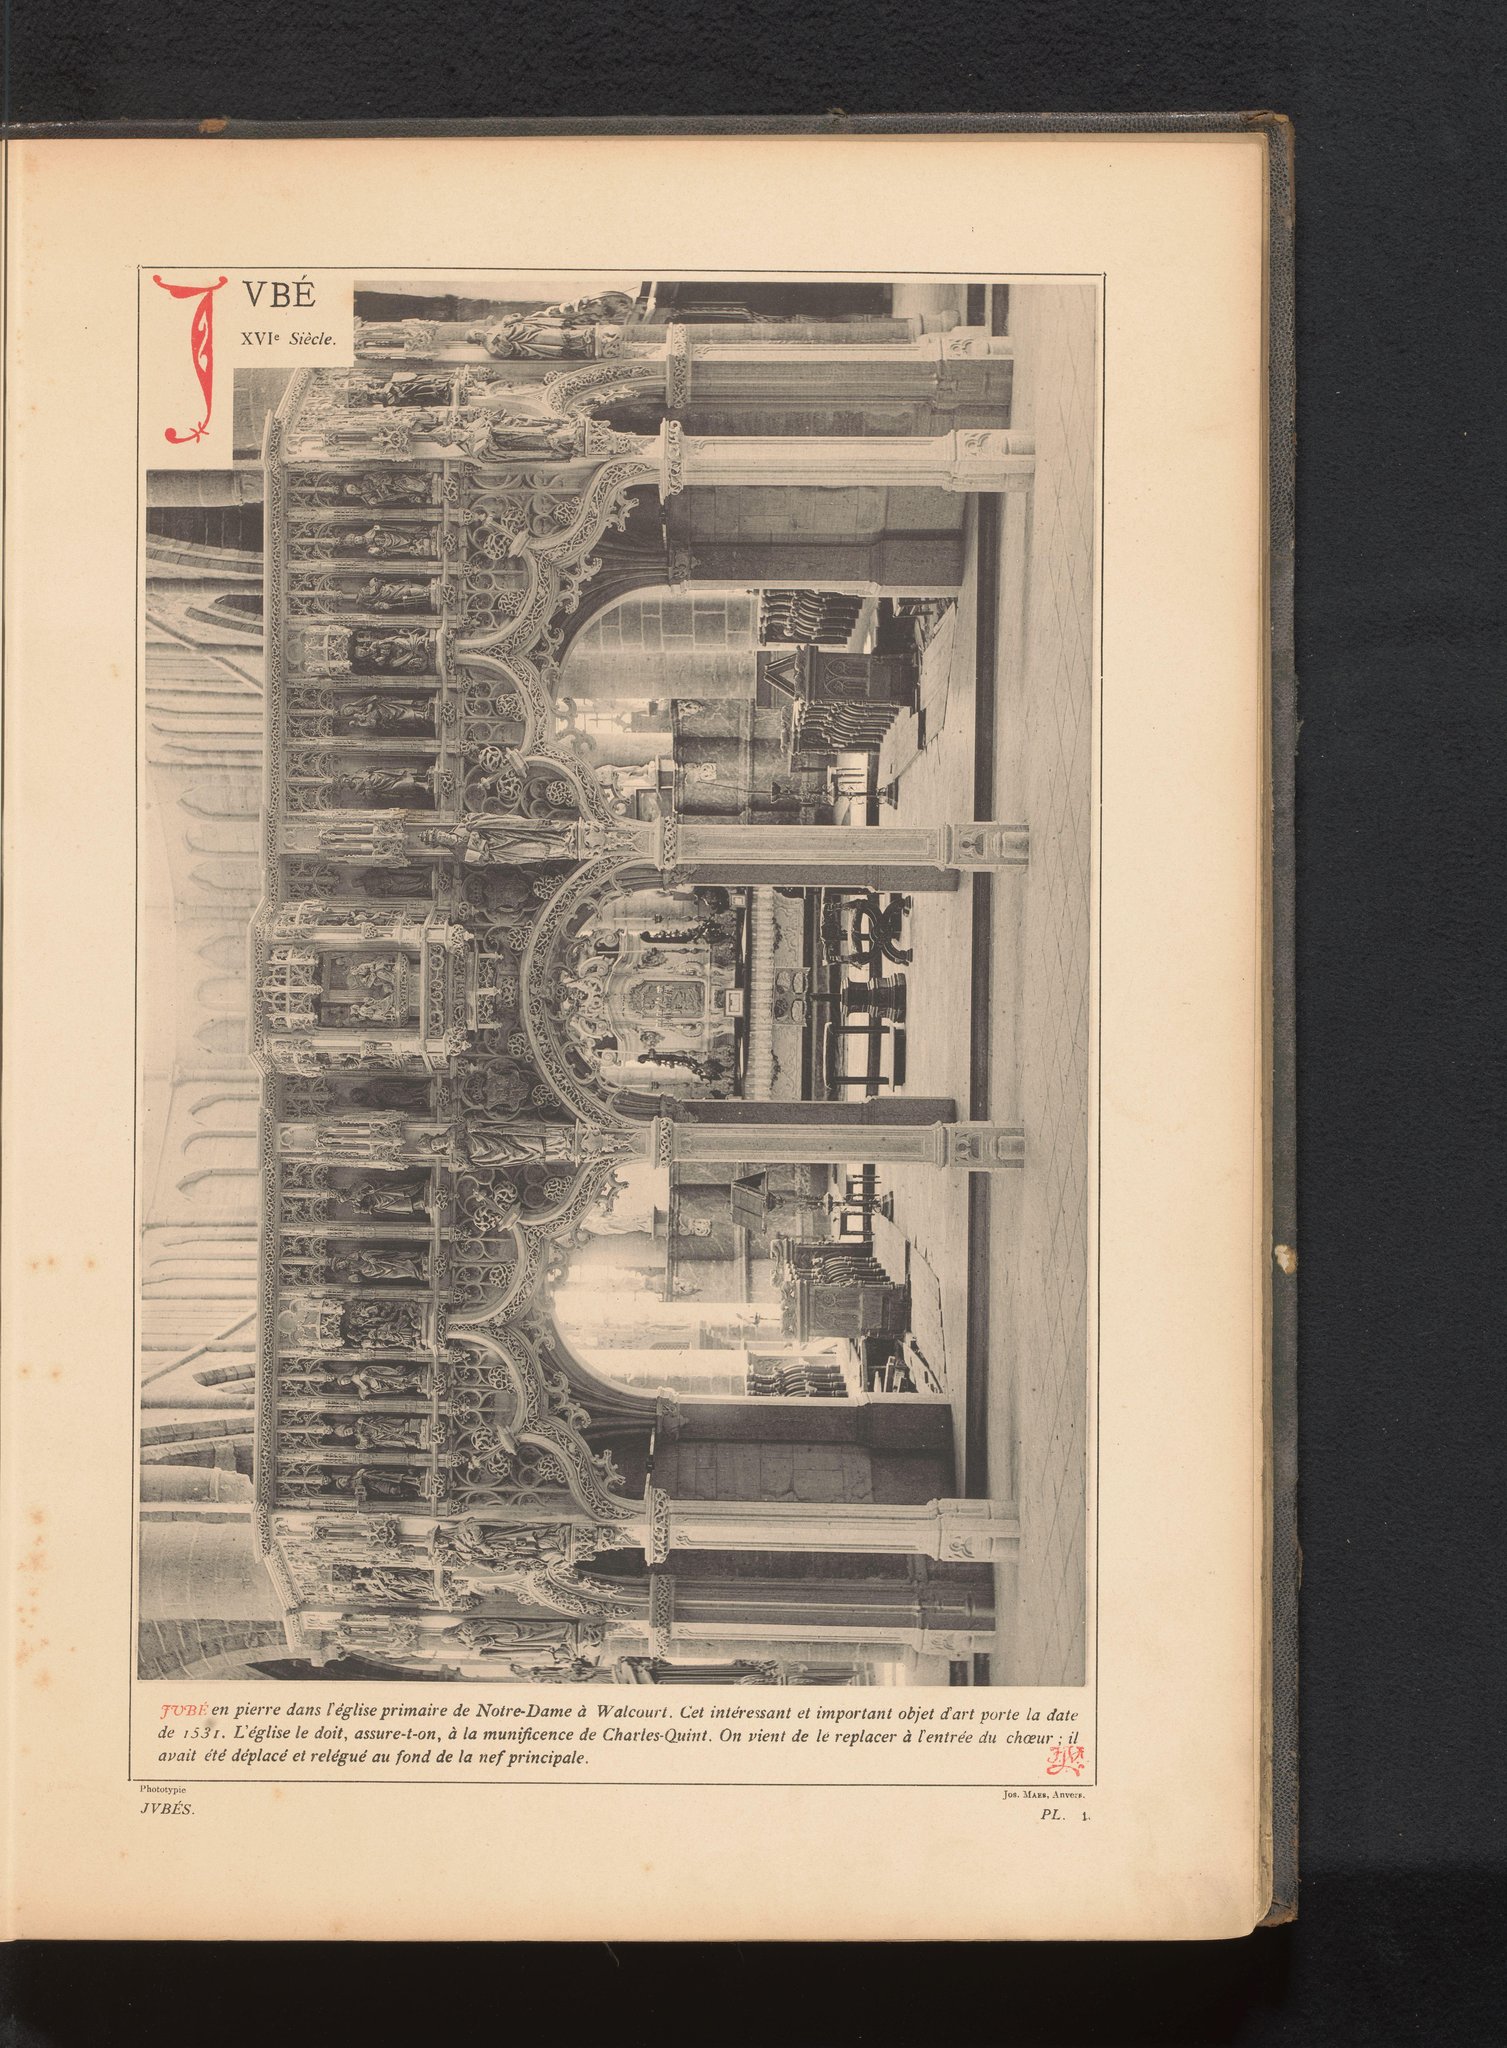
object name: page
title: Doksaal in de Sint-Maternusbasiliek te Walcourt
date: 1881-1889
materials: paper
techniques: photograph, photolithography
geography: walcourt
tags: rood-screen, choir-screen; iconostasis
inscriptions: monogram: ‘JJvY’, inscription: ‘JUBÉ en pierre (...)’, inscription: ‘JUBÉS. PL. 1.’